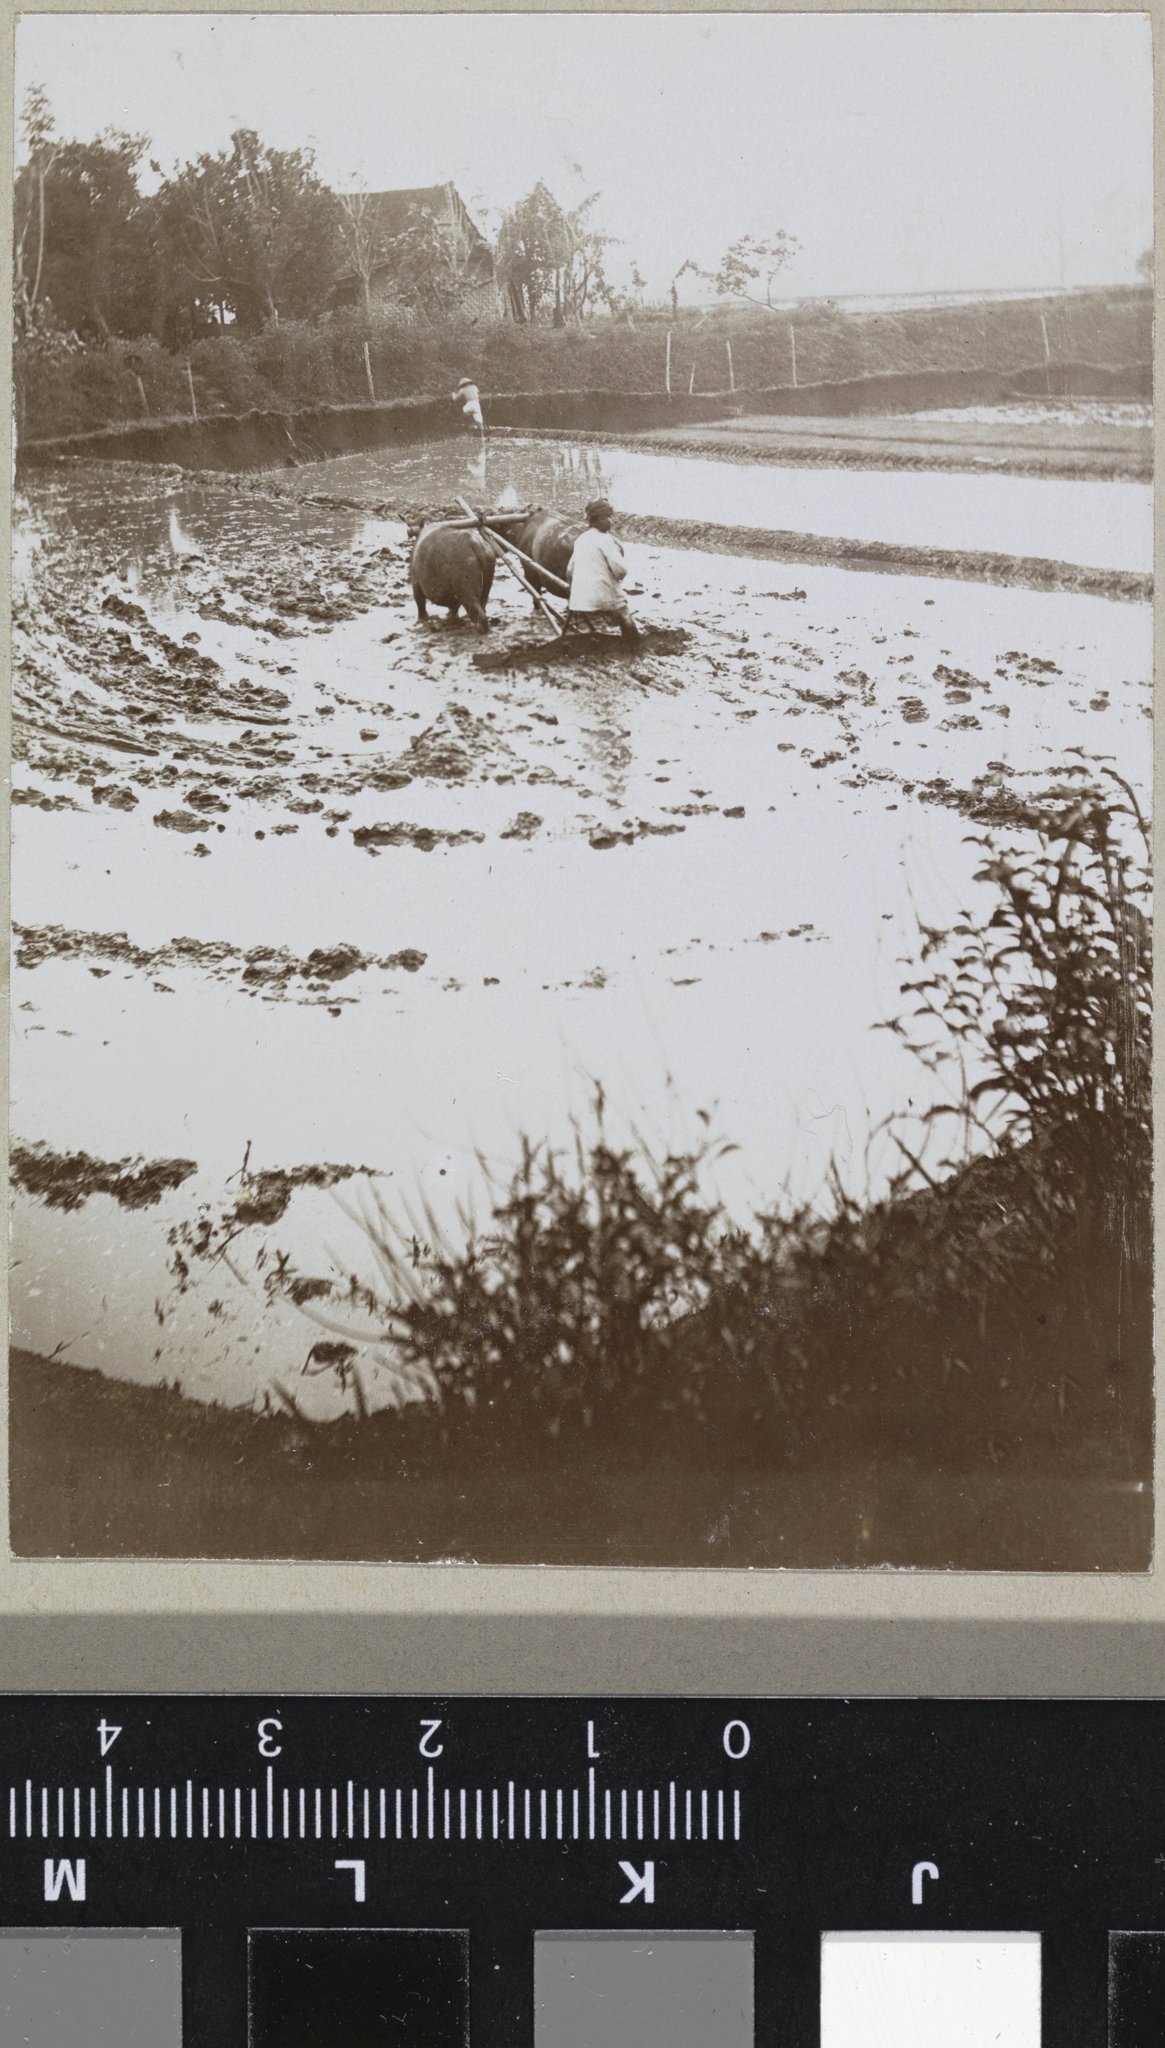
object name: photograph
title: Ploegende man in een rijstveld, Nederlands-Indië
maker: Anonymous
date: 1895-1915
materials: cardboard, paper, photographic support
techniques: collodion silver print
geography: dutch east indies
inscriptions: annotation: ‘3 & 4) ploegen in een rijstveld met karbouwen’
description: Ploeg voortgetrokken door twee karbouwen.